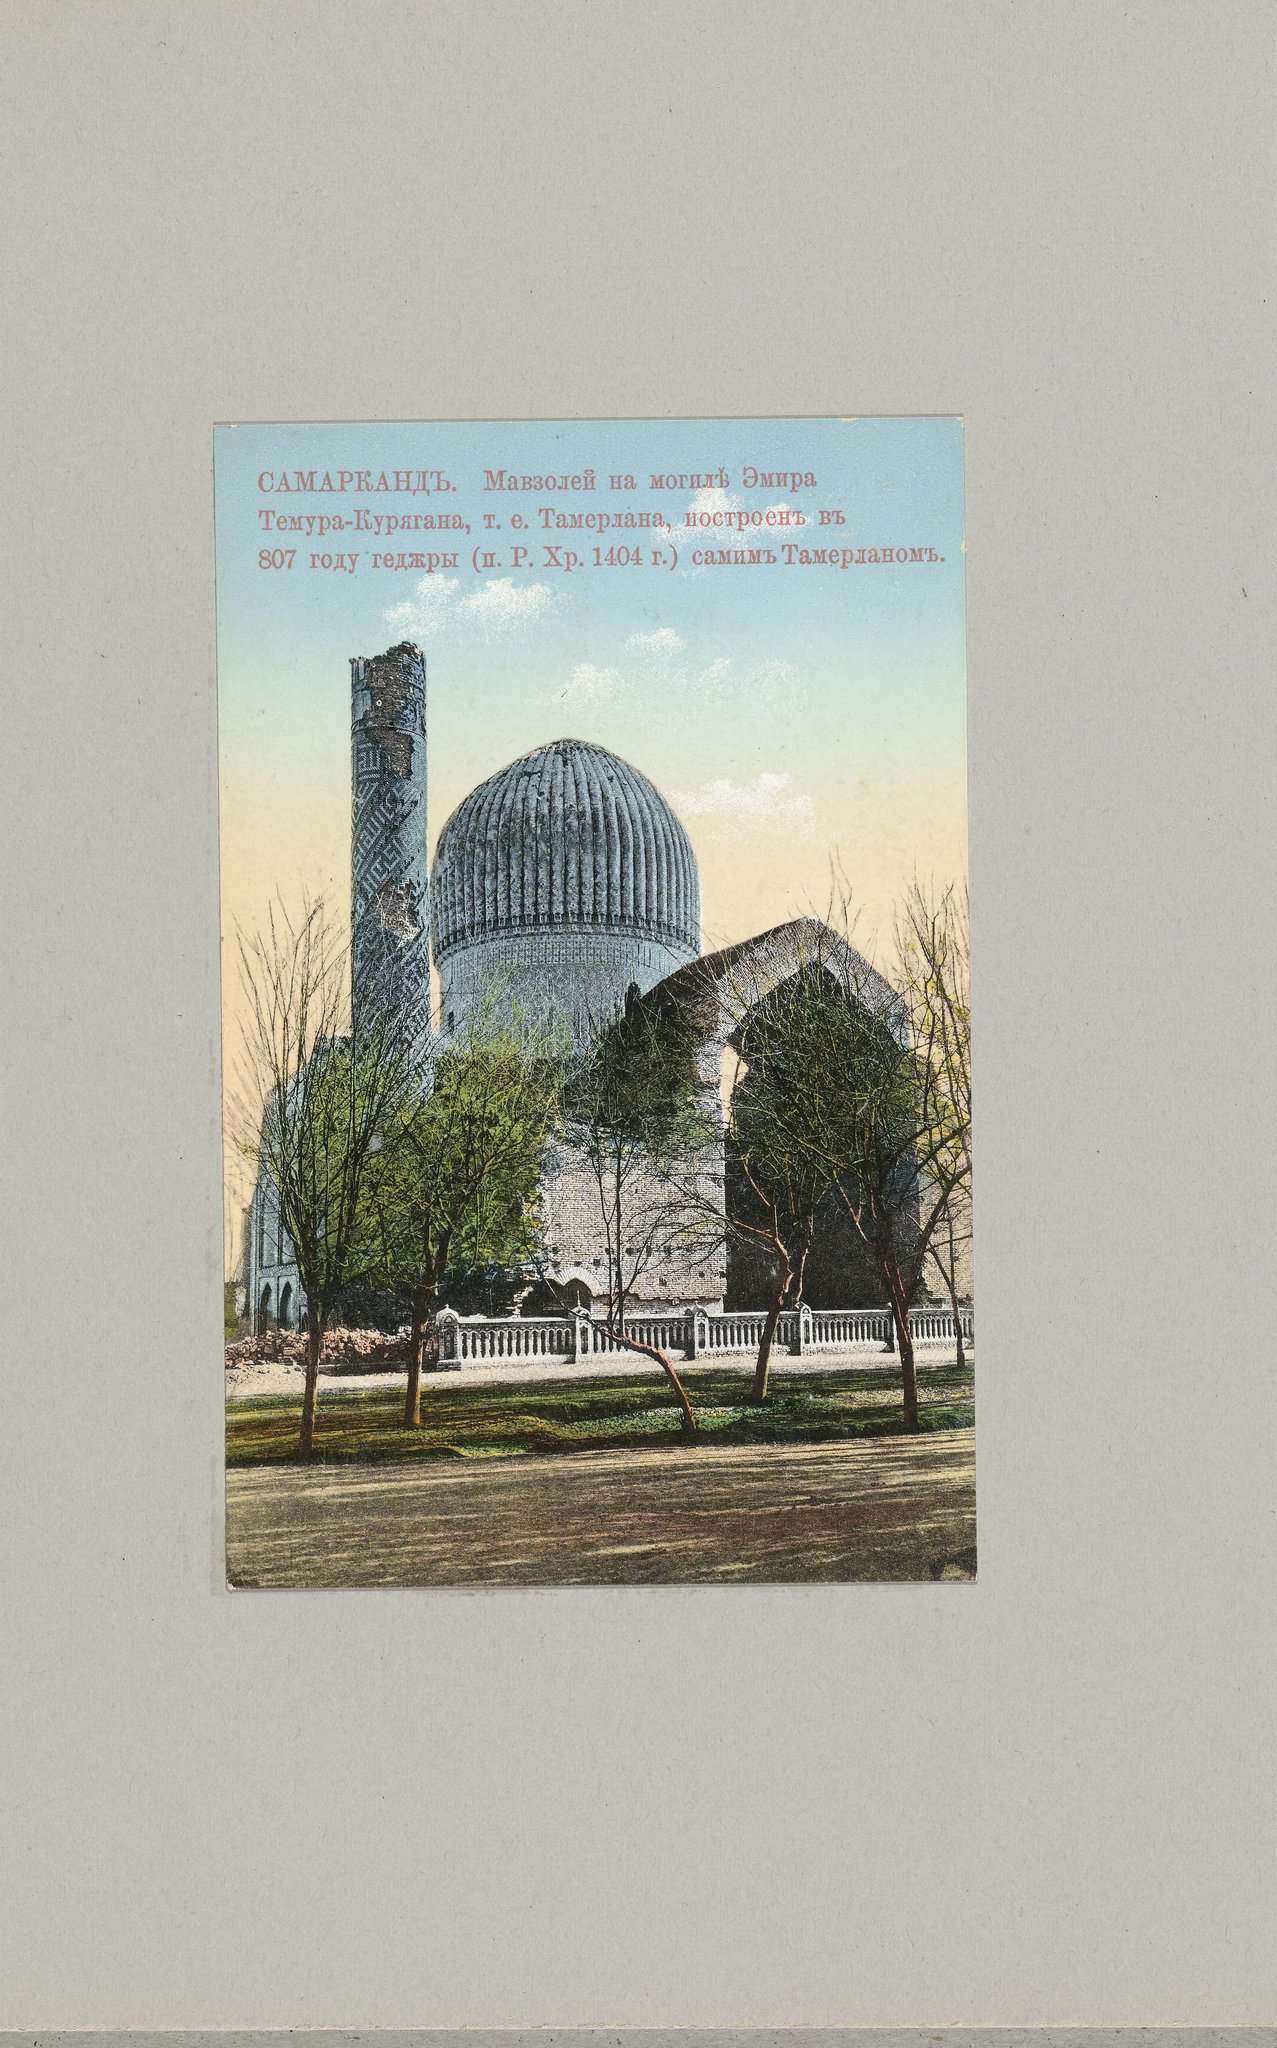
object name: photomechanical print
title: Mausoleum van Timur te Samarkand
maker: Anonymous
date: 1895-1915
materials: cardboard, paper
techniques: photograph, lithograph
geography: samarqand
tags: samarqand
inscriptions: annotation: ‘8 & 6 (verglaasde tegels.) / Nº 9.’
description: Mausoleum, bovenaan staat uitleg in het Oezbeeks.